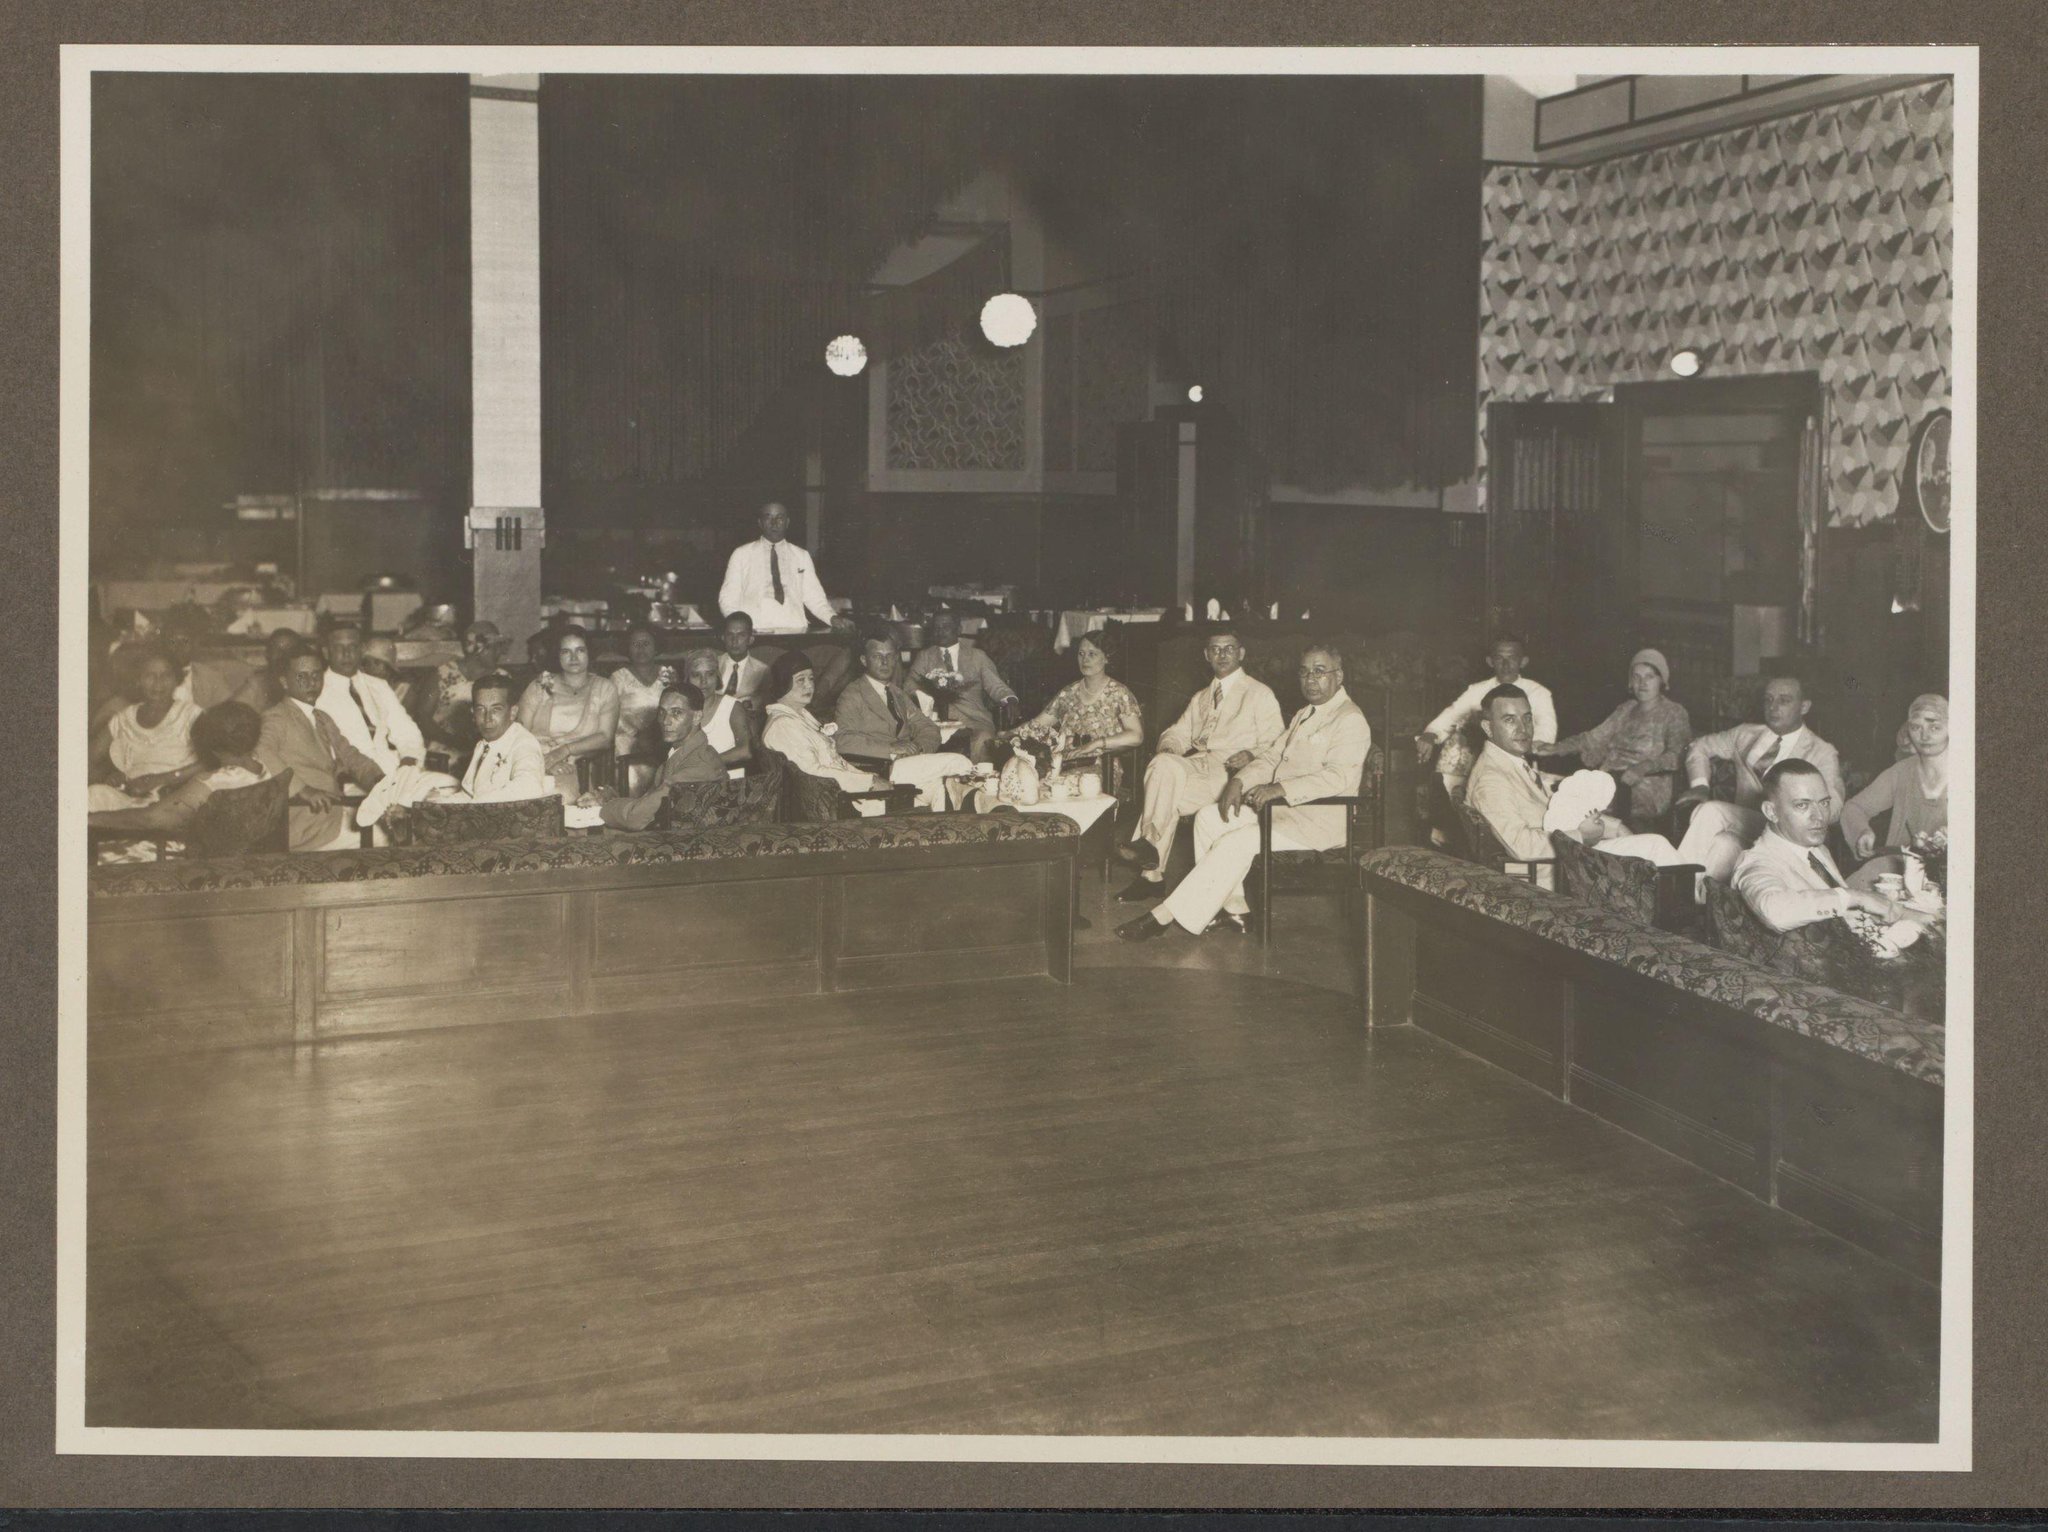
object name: photograph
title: Thé dansant op 19 April 1931.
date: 1904-1931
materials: photographic support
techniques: gelatin silver print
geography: surabaya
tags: colonial system, trade-company, ball, formal dance, surabaya, java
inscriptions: inscription: ‘Thé dansant op 19 April 1931.’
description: Thé dansant op 19 april ter gelegenheid van het afscheid. Zaal met gasten zittend aan tafels rond de dansvloer. Foto in het het fotoalbum aangeboden aan A. van der Eyk namens de chefs en het personeel van de Handelsvereniging Amsterdam (HVA) te Soerabaja bij zijn vertrek van Java in april 1931.